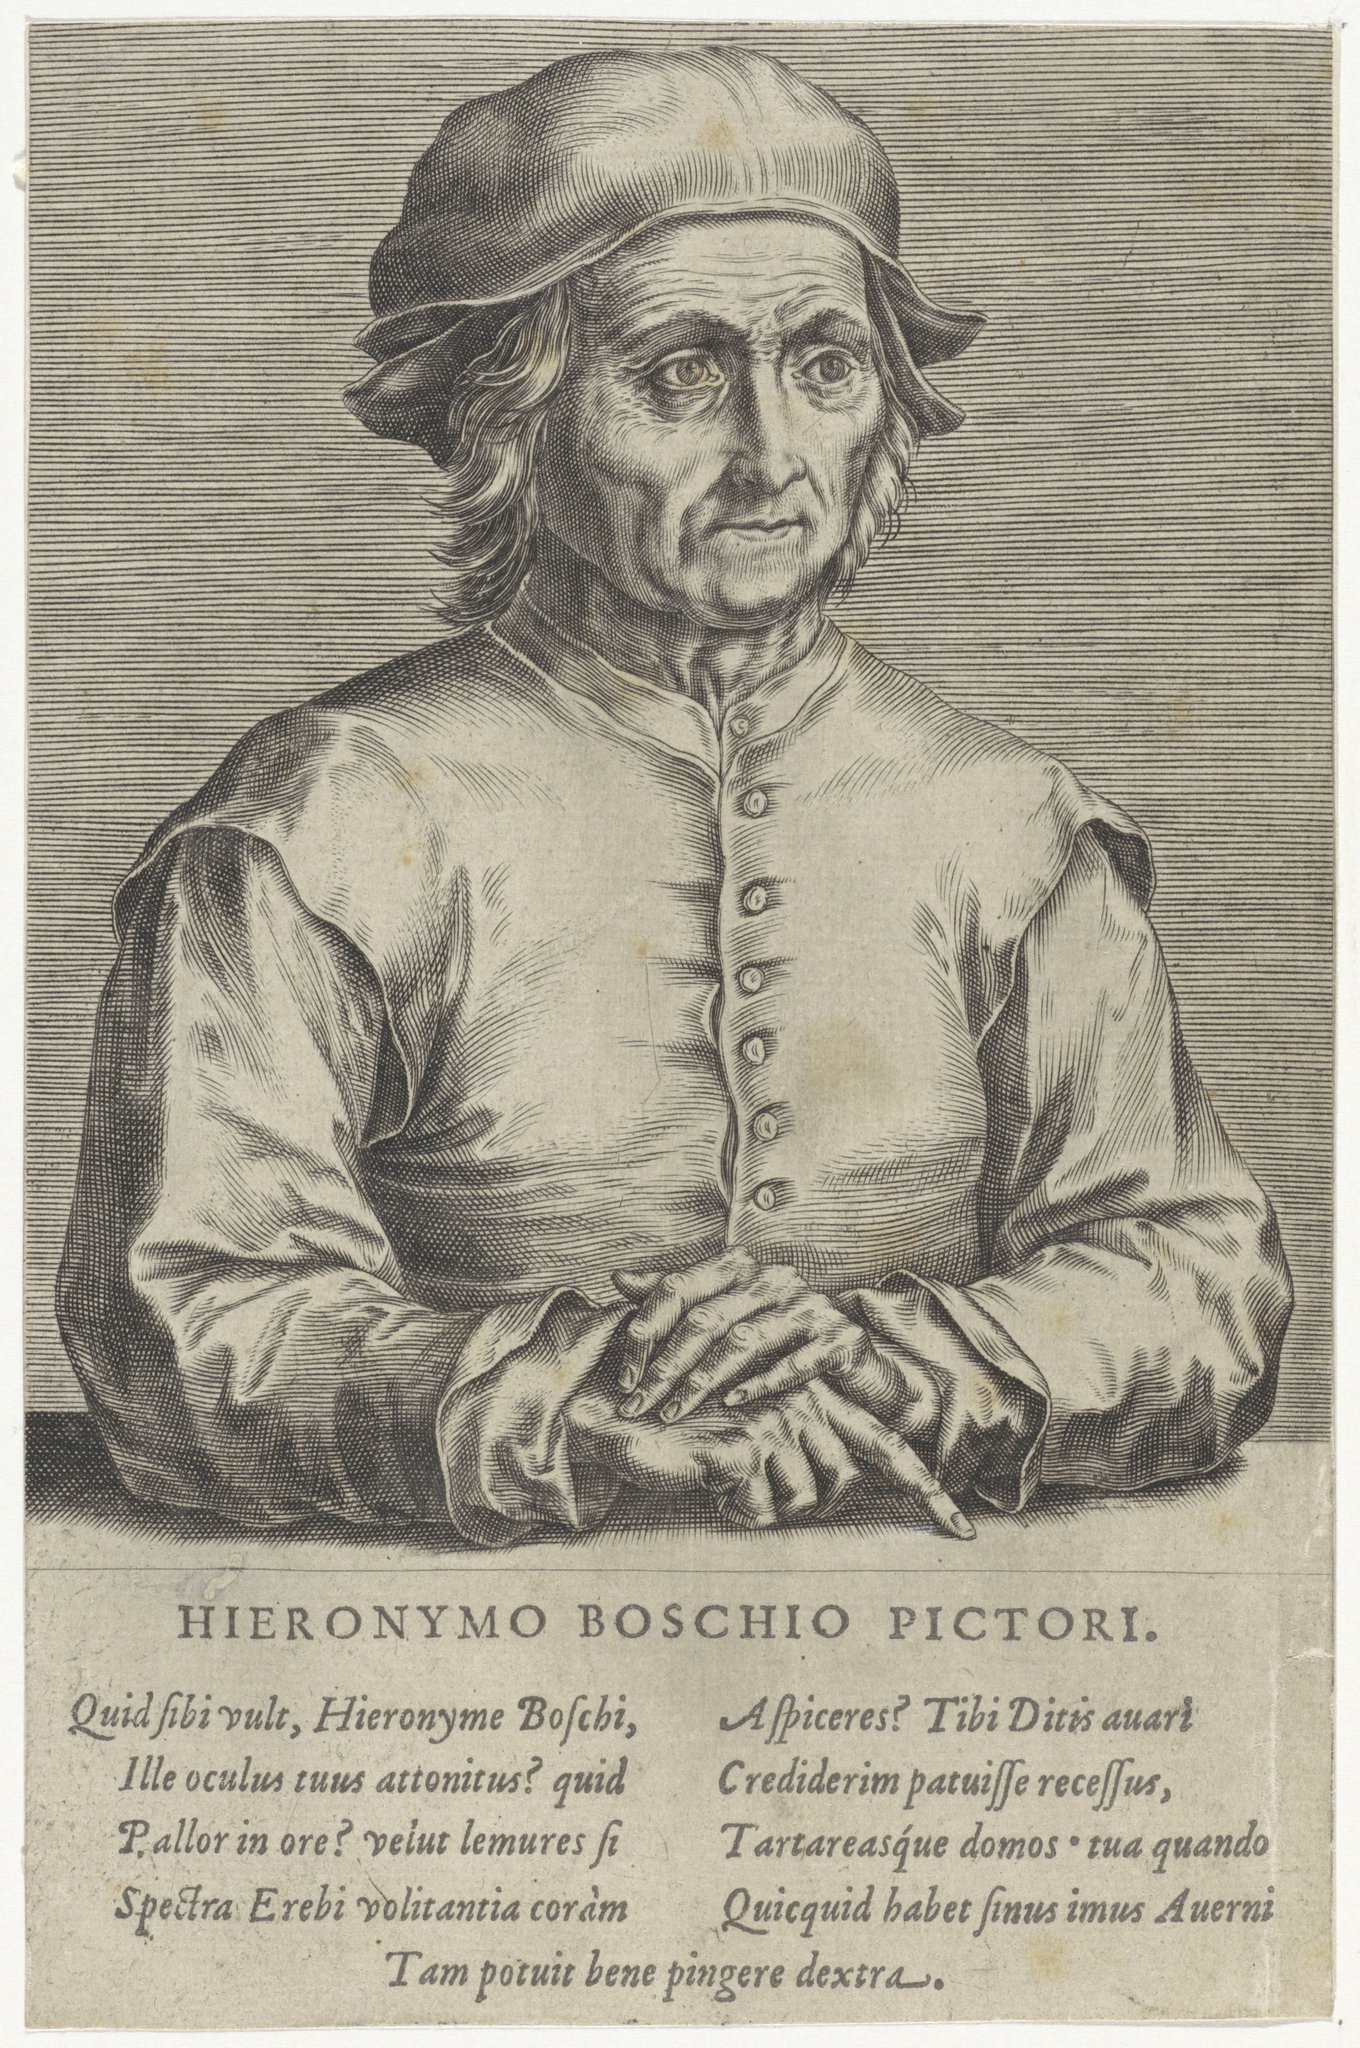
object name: print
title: Portretten van schilders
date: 1572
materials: paper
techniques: engraving, letterpress printing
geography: antwerp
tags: den bosch, painter, draughtsman, jheronimus bosch, portrait, self-portrait of painter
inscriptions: collector's mark: Lugt 2165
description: Portret van de schilder Jheronimus Bosch. In de marge een negenregelig onderschrift, in drie kolommen, in het Latijn.